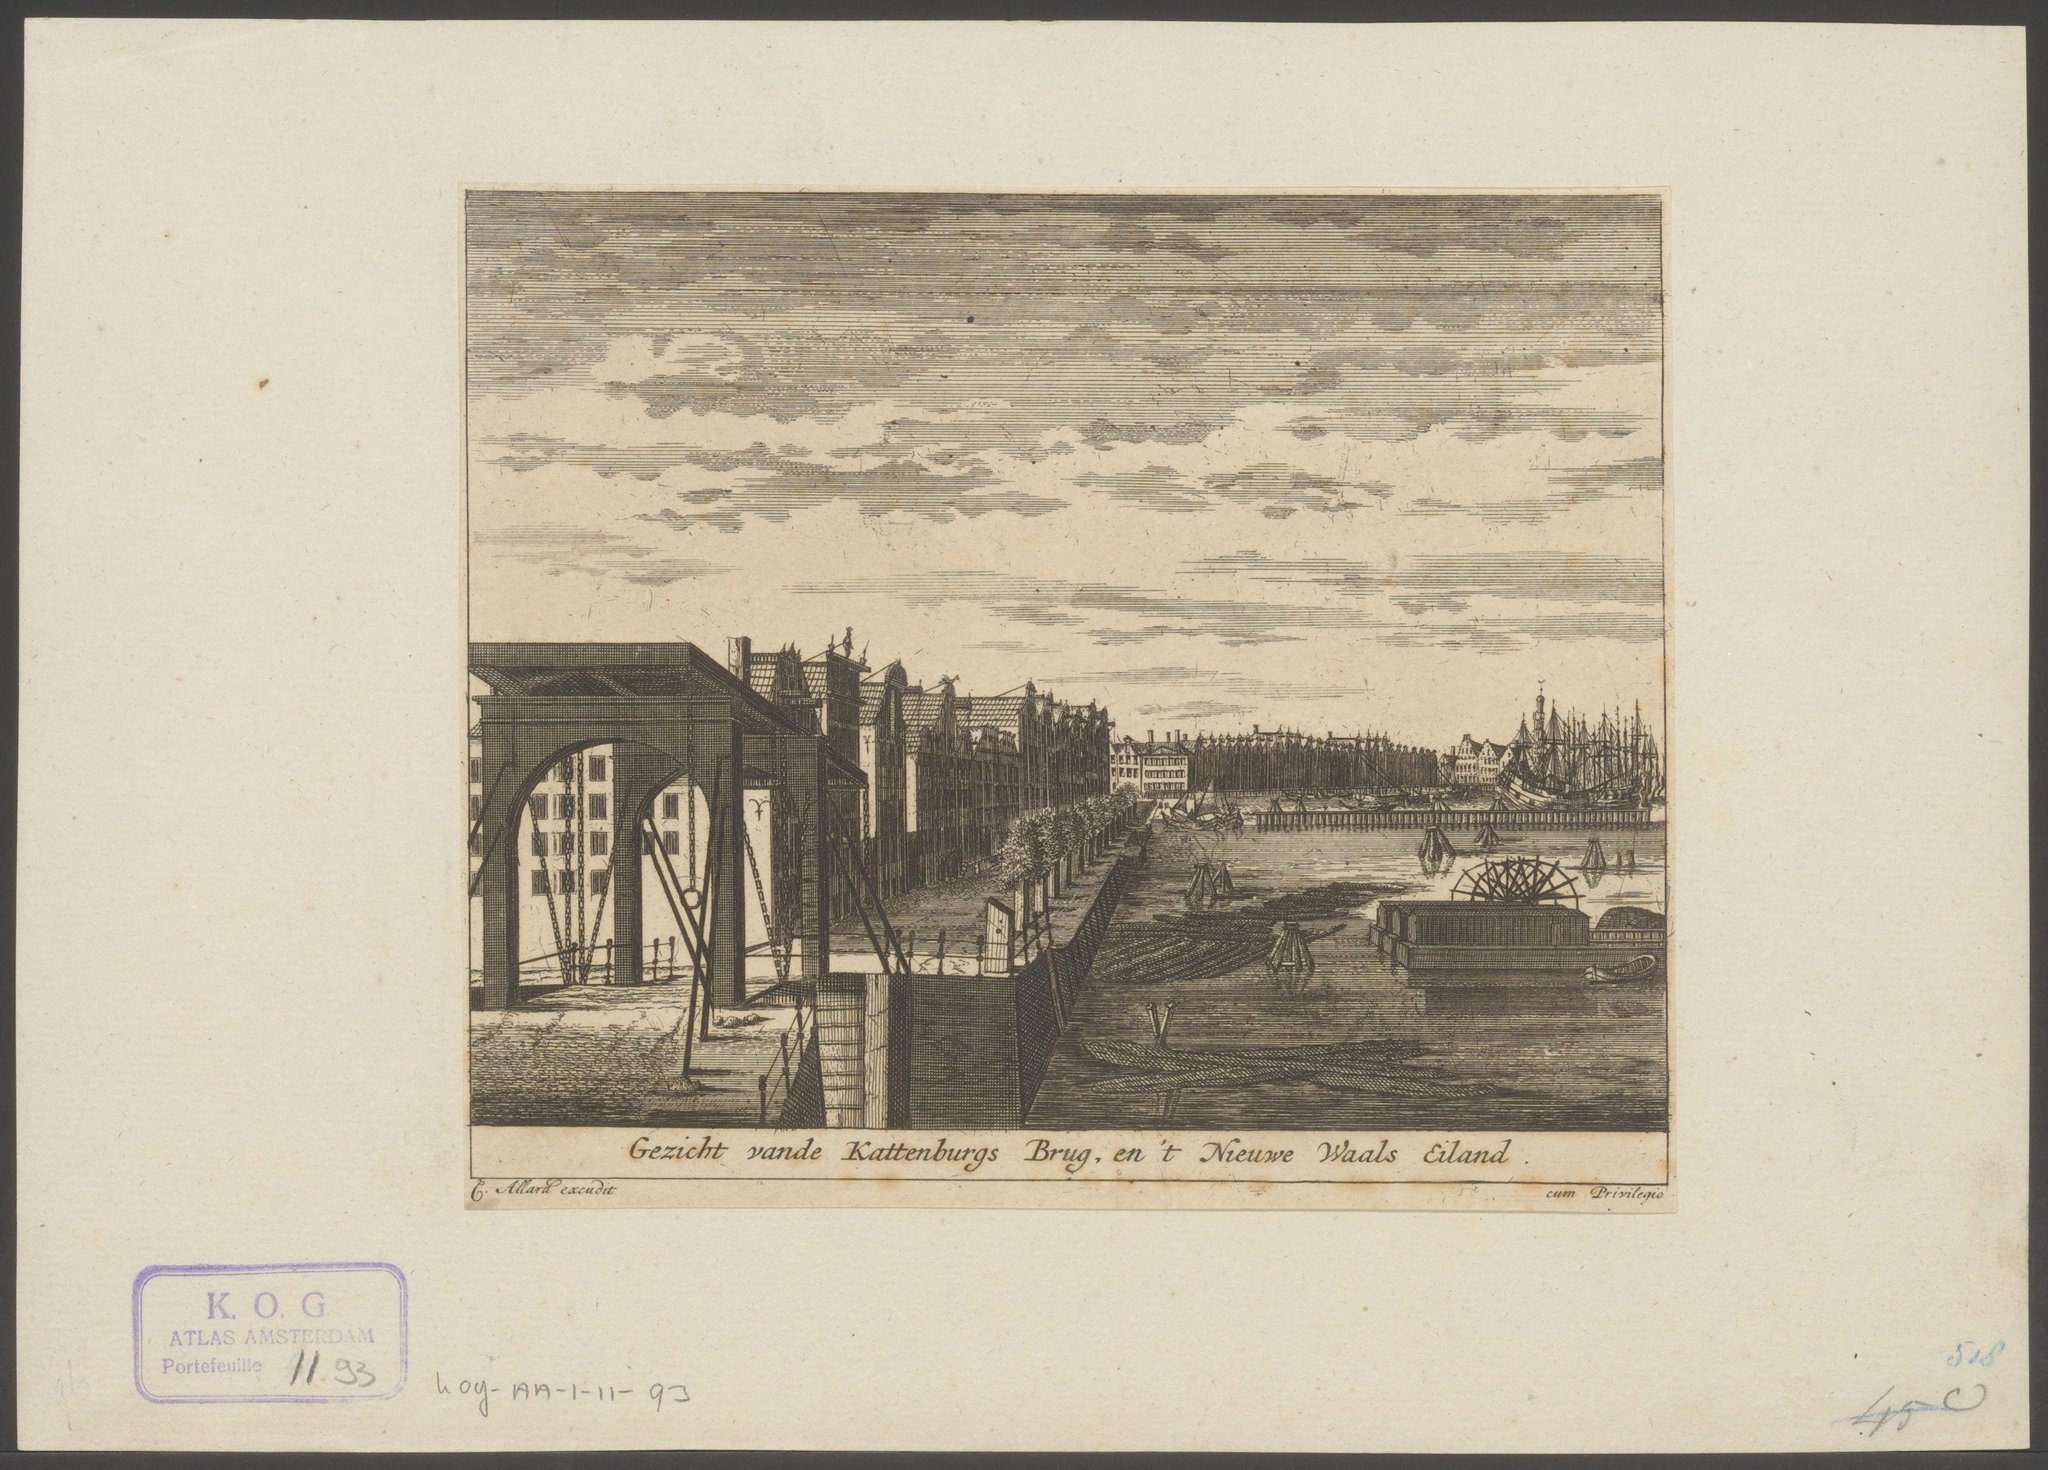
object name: print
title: Gezicht op de Prins Hendrikkade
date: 1683-1709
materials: paper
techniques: etching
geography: amsterdam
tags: city-view in general; 'veduta', river, bridge in city across river, canal, etc., street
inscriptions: collector's mark: ‘11.93’ Lugt 1641b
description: Onderwerpsrubriek binnen de Atlas Amsterdam: Prinsengracht, Korte Prinsengracht, Prins Hendrikkade. Zie ook Portefeuille 1: gezichten van het IJ op de stad.